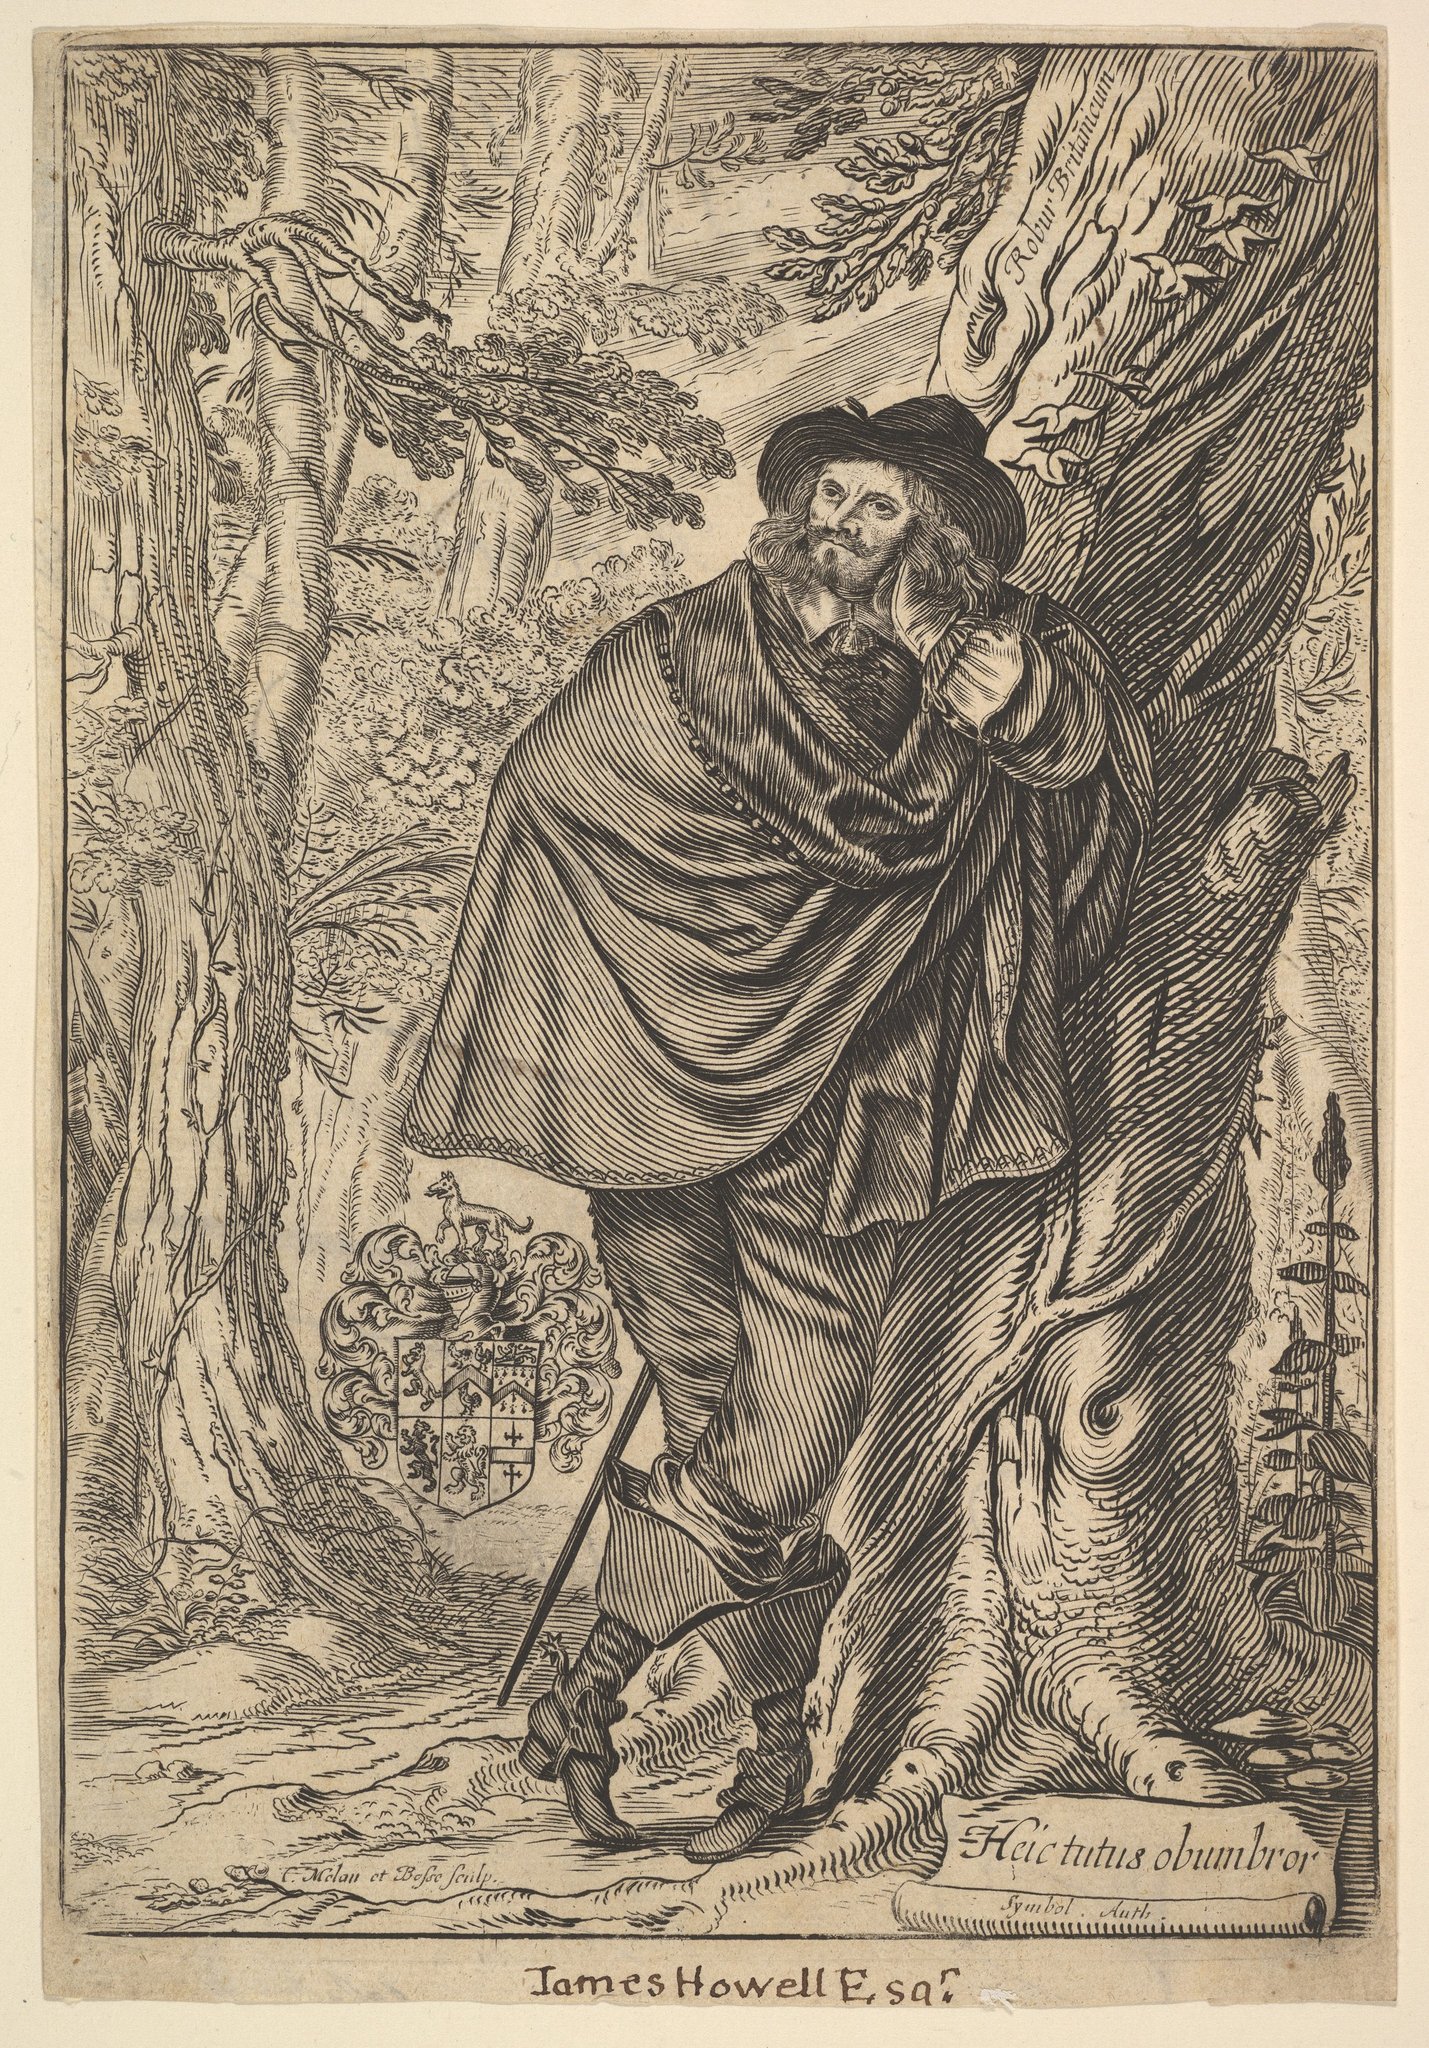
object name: print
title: James Howell Standing in a Forest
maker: claude mellan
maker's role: artist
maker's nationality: french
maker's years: 1598-1688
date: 1641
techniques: engraving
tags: men,coat of arms